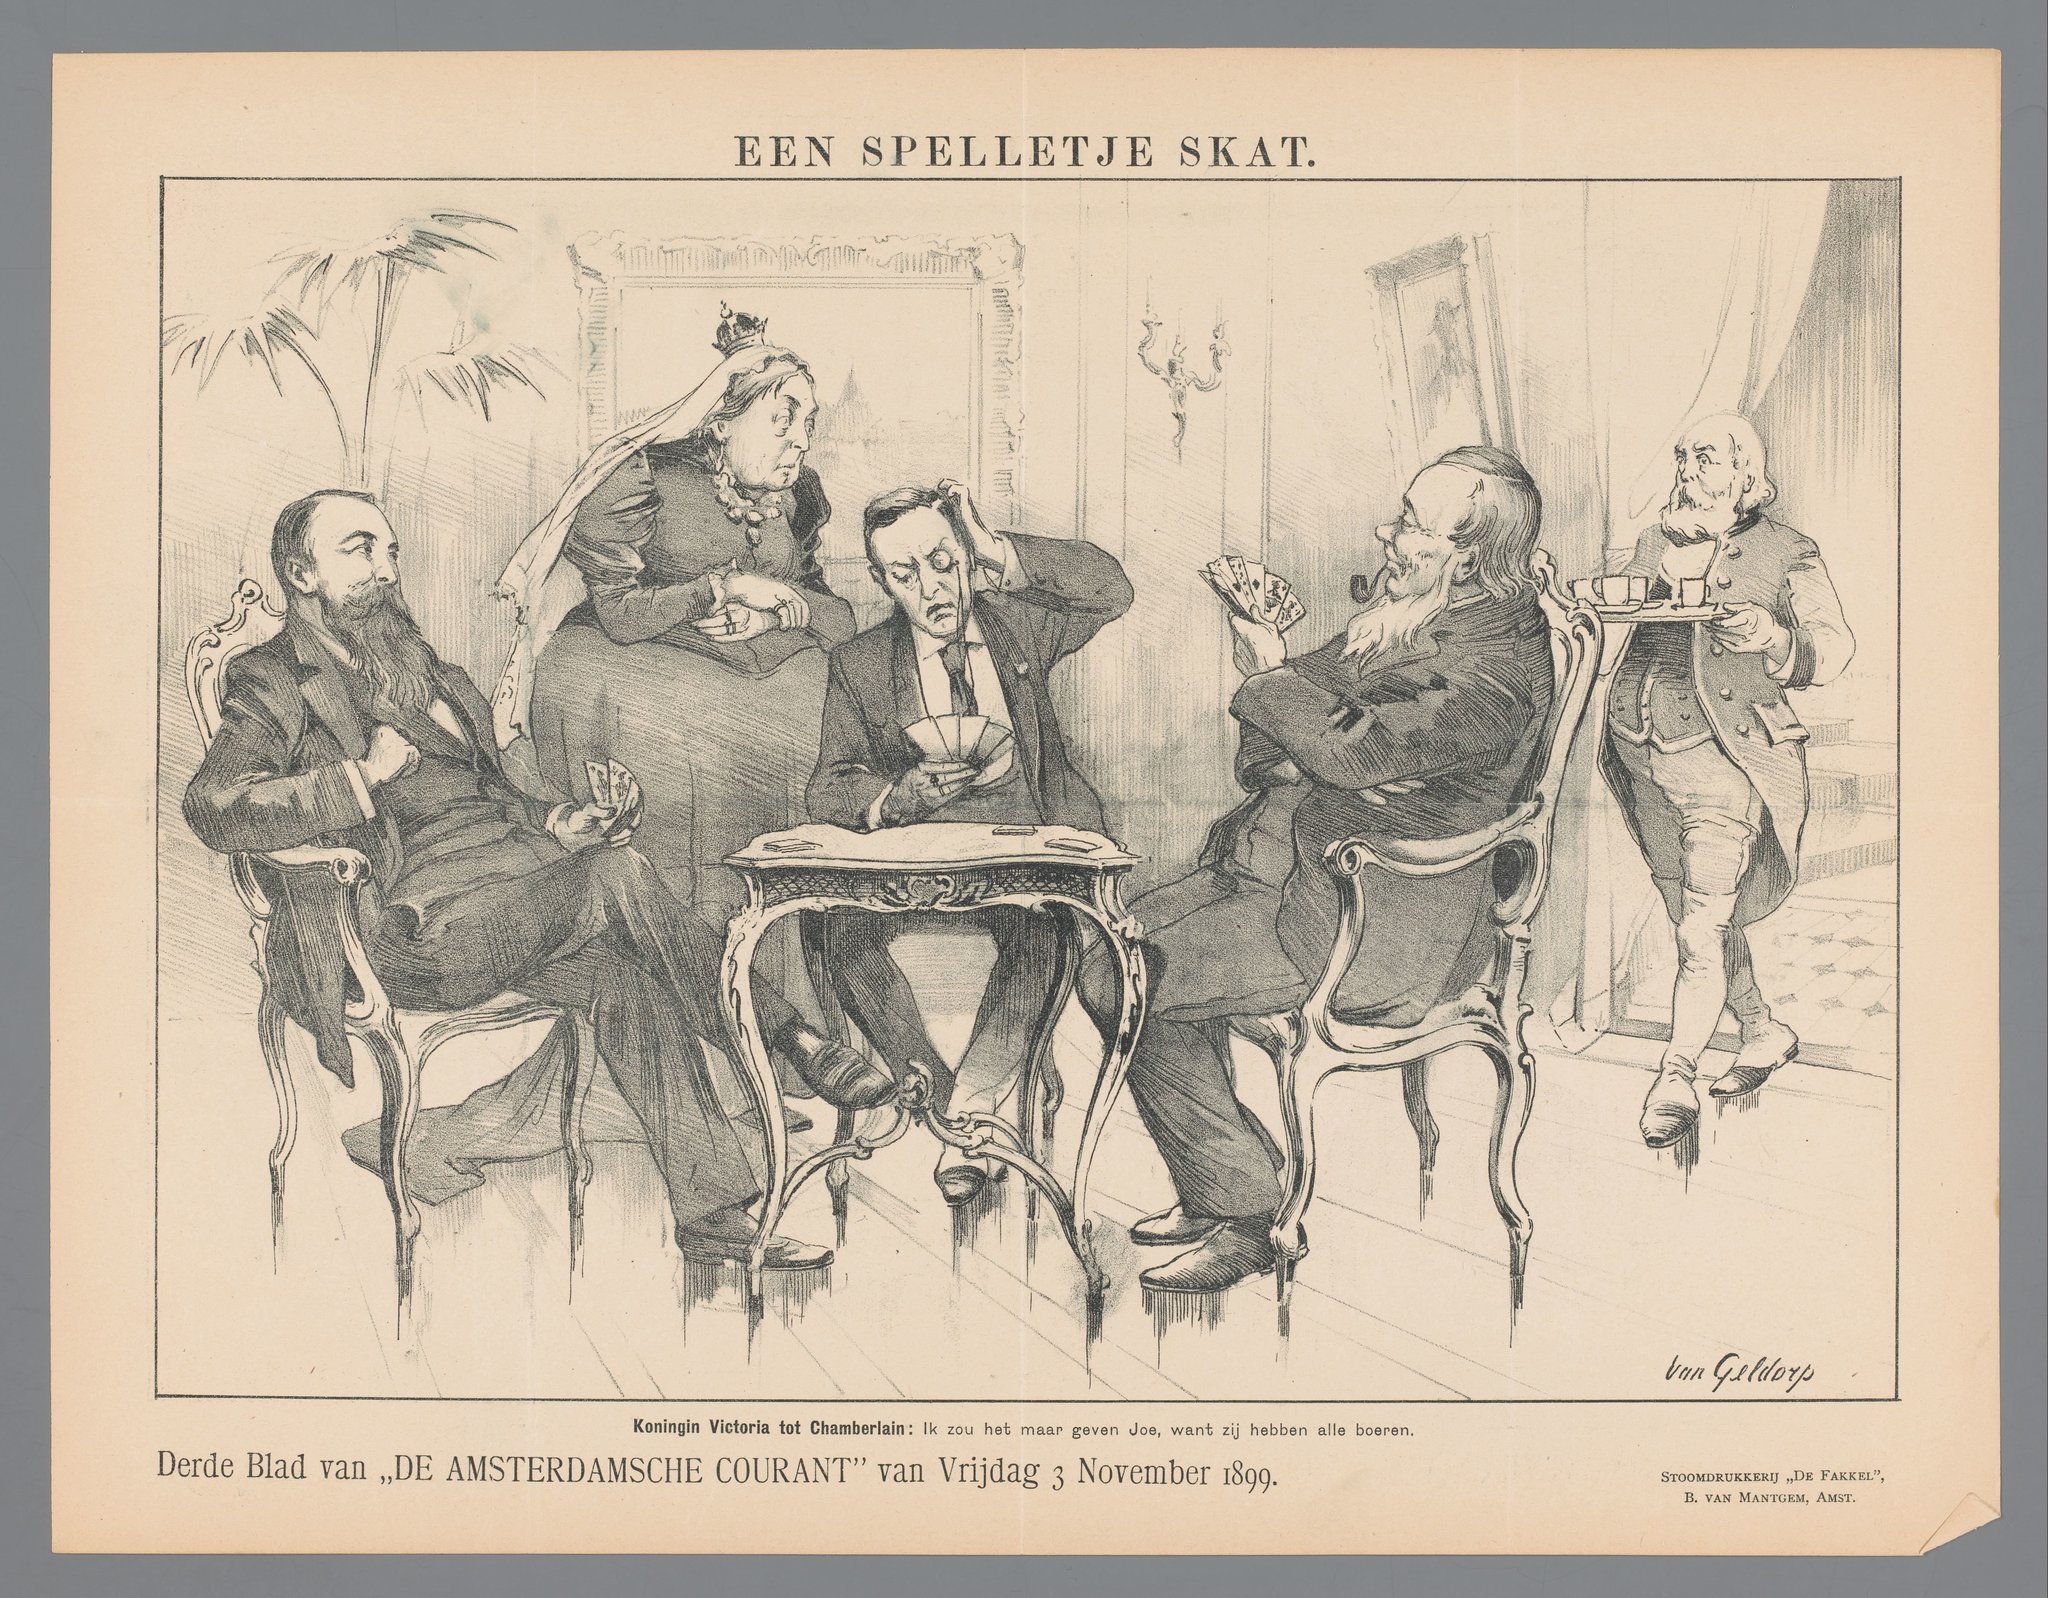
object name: cartoon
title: Een spelletje Skat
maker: petrus van geldorp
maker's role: draughtsman, print maker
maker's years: 1872-1939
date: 1899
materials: paper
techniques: lithograph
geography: amsterdam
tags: victoria (koningin van het verenigd koninkrijk en keizerin van india), politician, historical persons, queen, politician, e.g. party leader, political caricatures and satires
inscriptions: date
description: Prent uit het bijvoegsel van: De Amsterdamsche Courant, 3 november 1899.